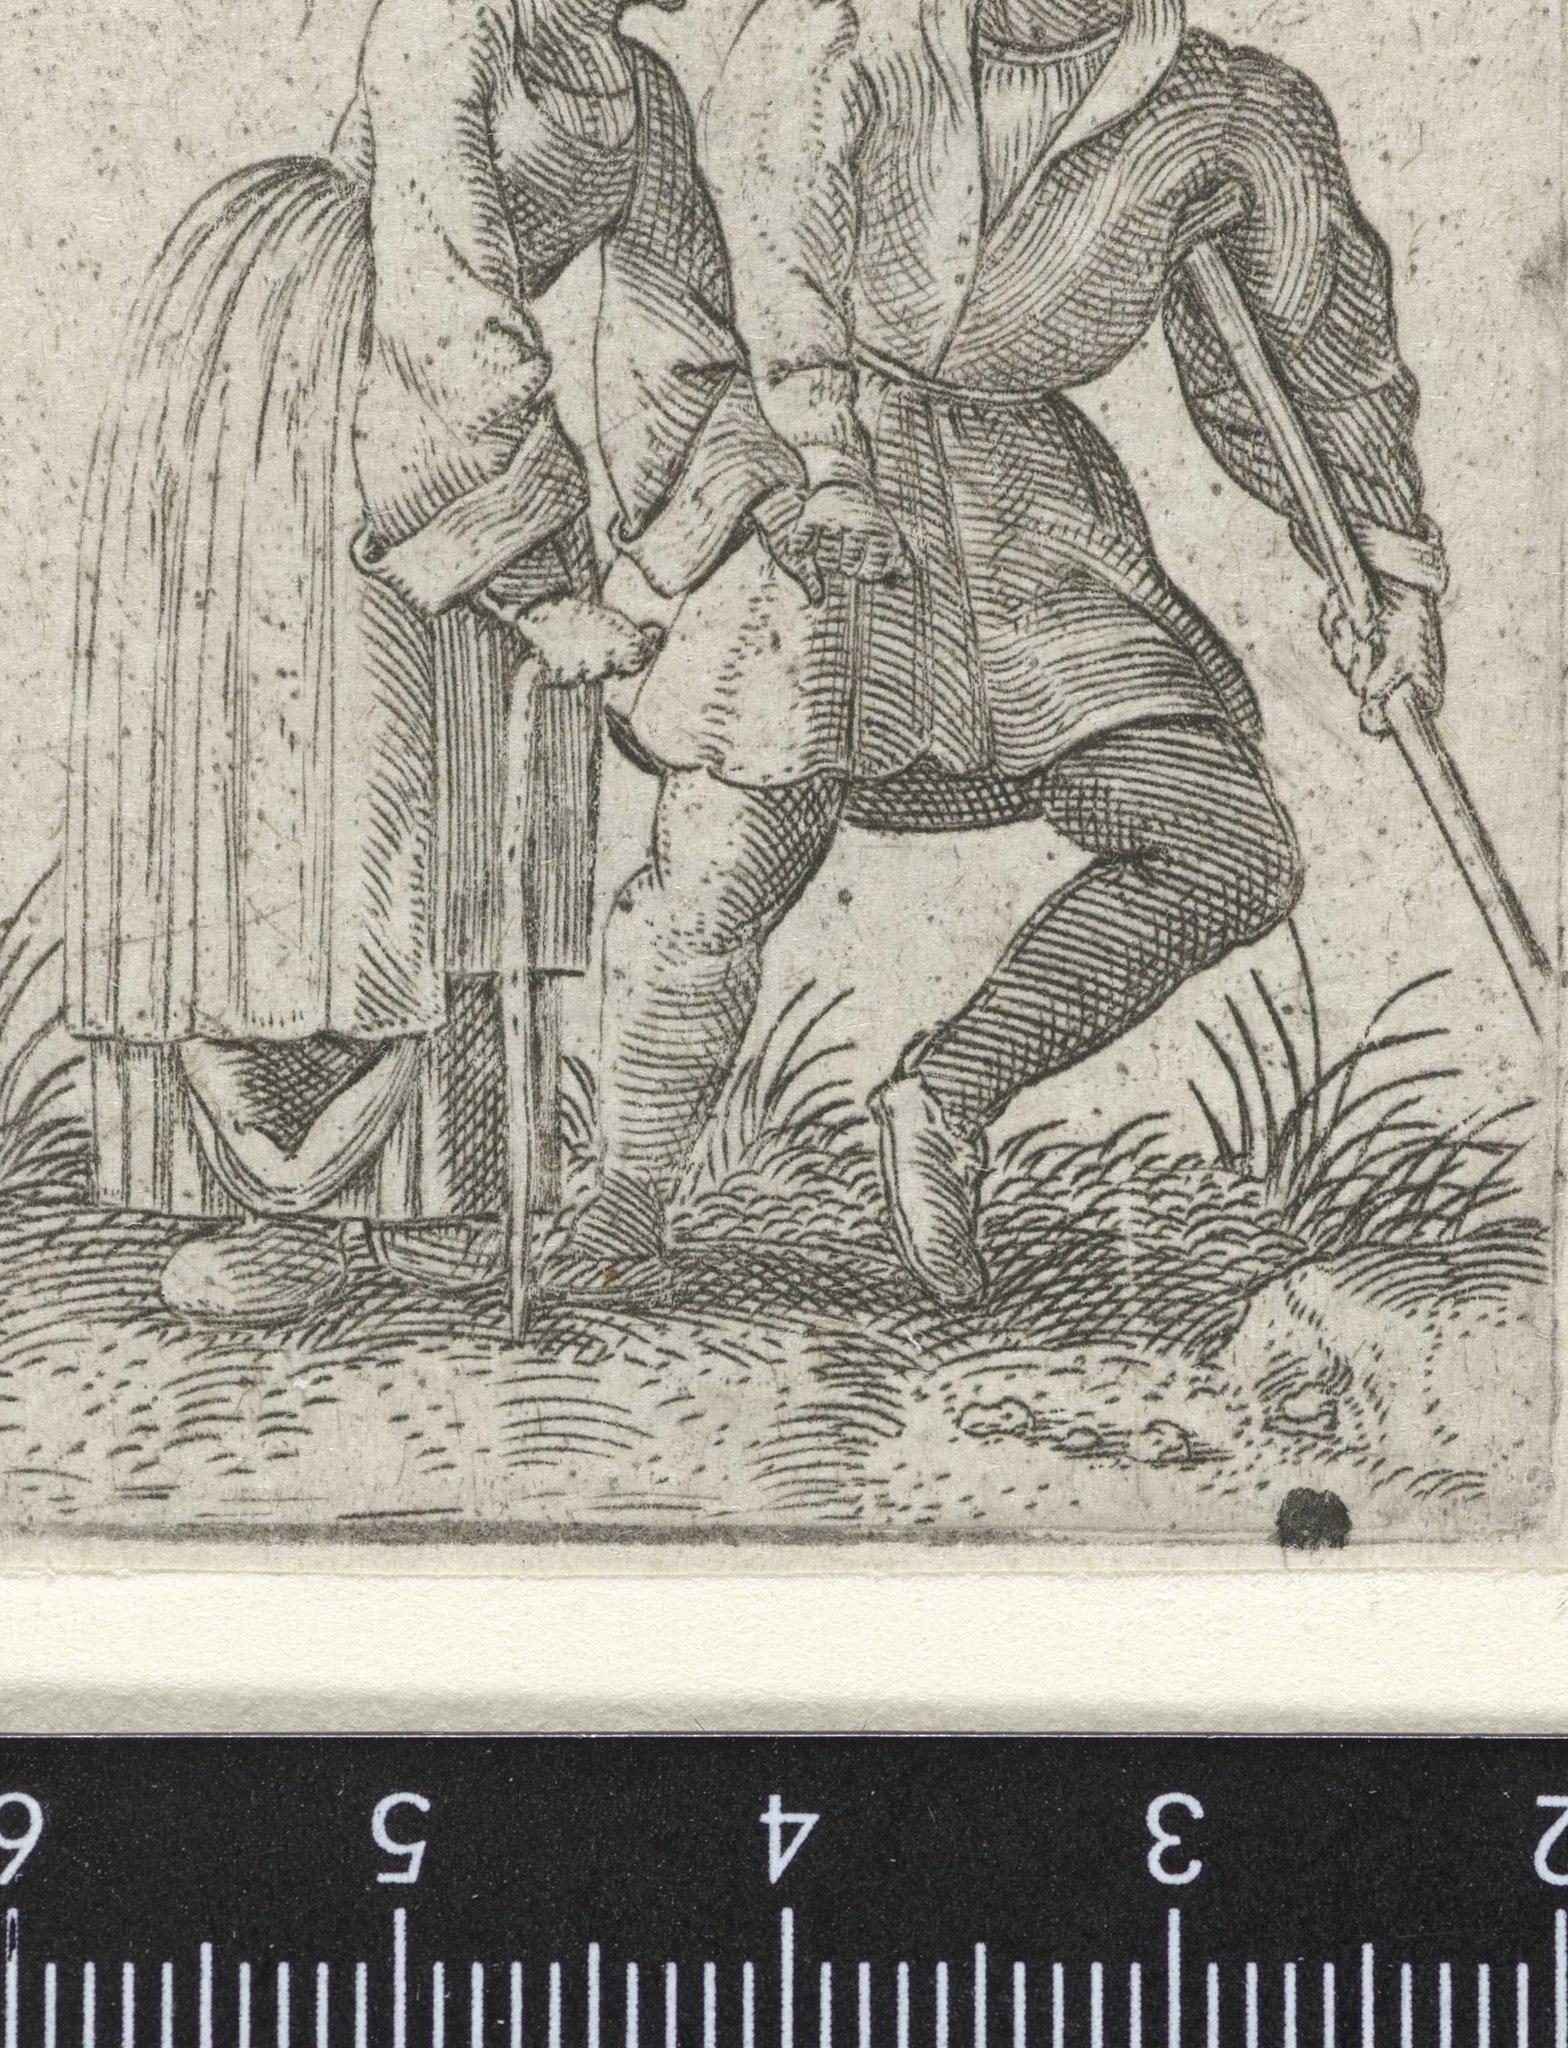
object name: print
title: Dansende kreupelen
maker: cornelis massijs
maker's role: painter, print maker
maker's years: 1510-1557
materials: paper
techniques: engraving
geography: antwerp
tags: dancing, crutches, one pair dancing; man and woman dancing as a couple, person with a physical disability, social stratification, social groups, bourgeoisie, middle class, citizens, burghers, folk costume, regional costume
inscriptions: collector's mark: Lugt 2228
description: In de tijd waarin deze serie ontstond was 'kreupel' een generiek woord om een lichamelijke beperking aan het onderlichaam te beschrijven. Deze serie is sociale satire. Een man met een baret op het hoofd, leunend op een kruk, houdt de hand vast van een vrouw, die op een stok leunt. Zij gaan gekleed als burgers.